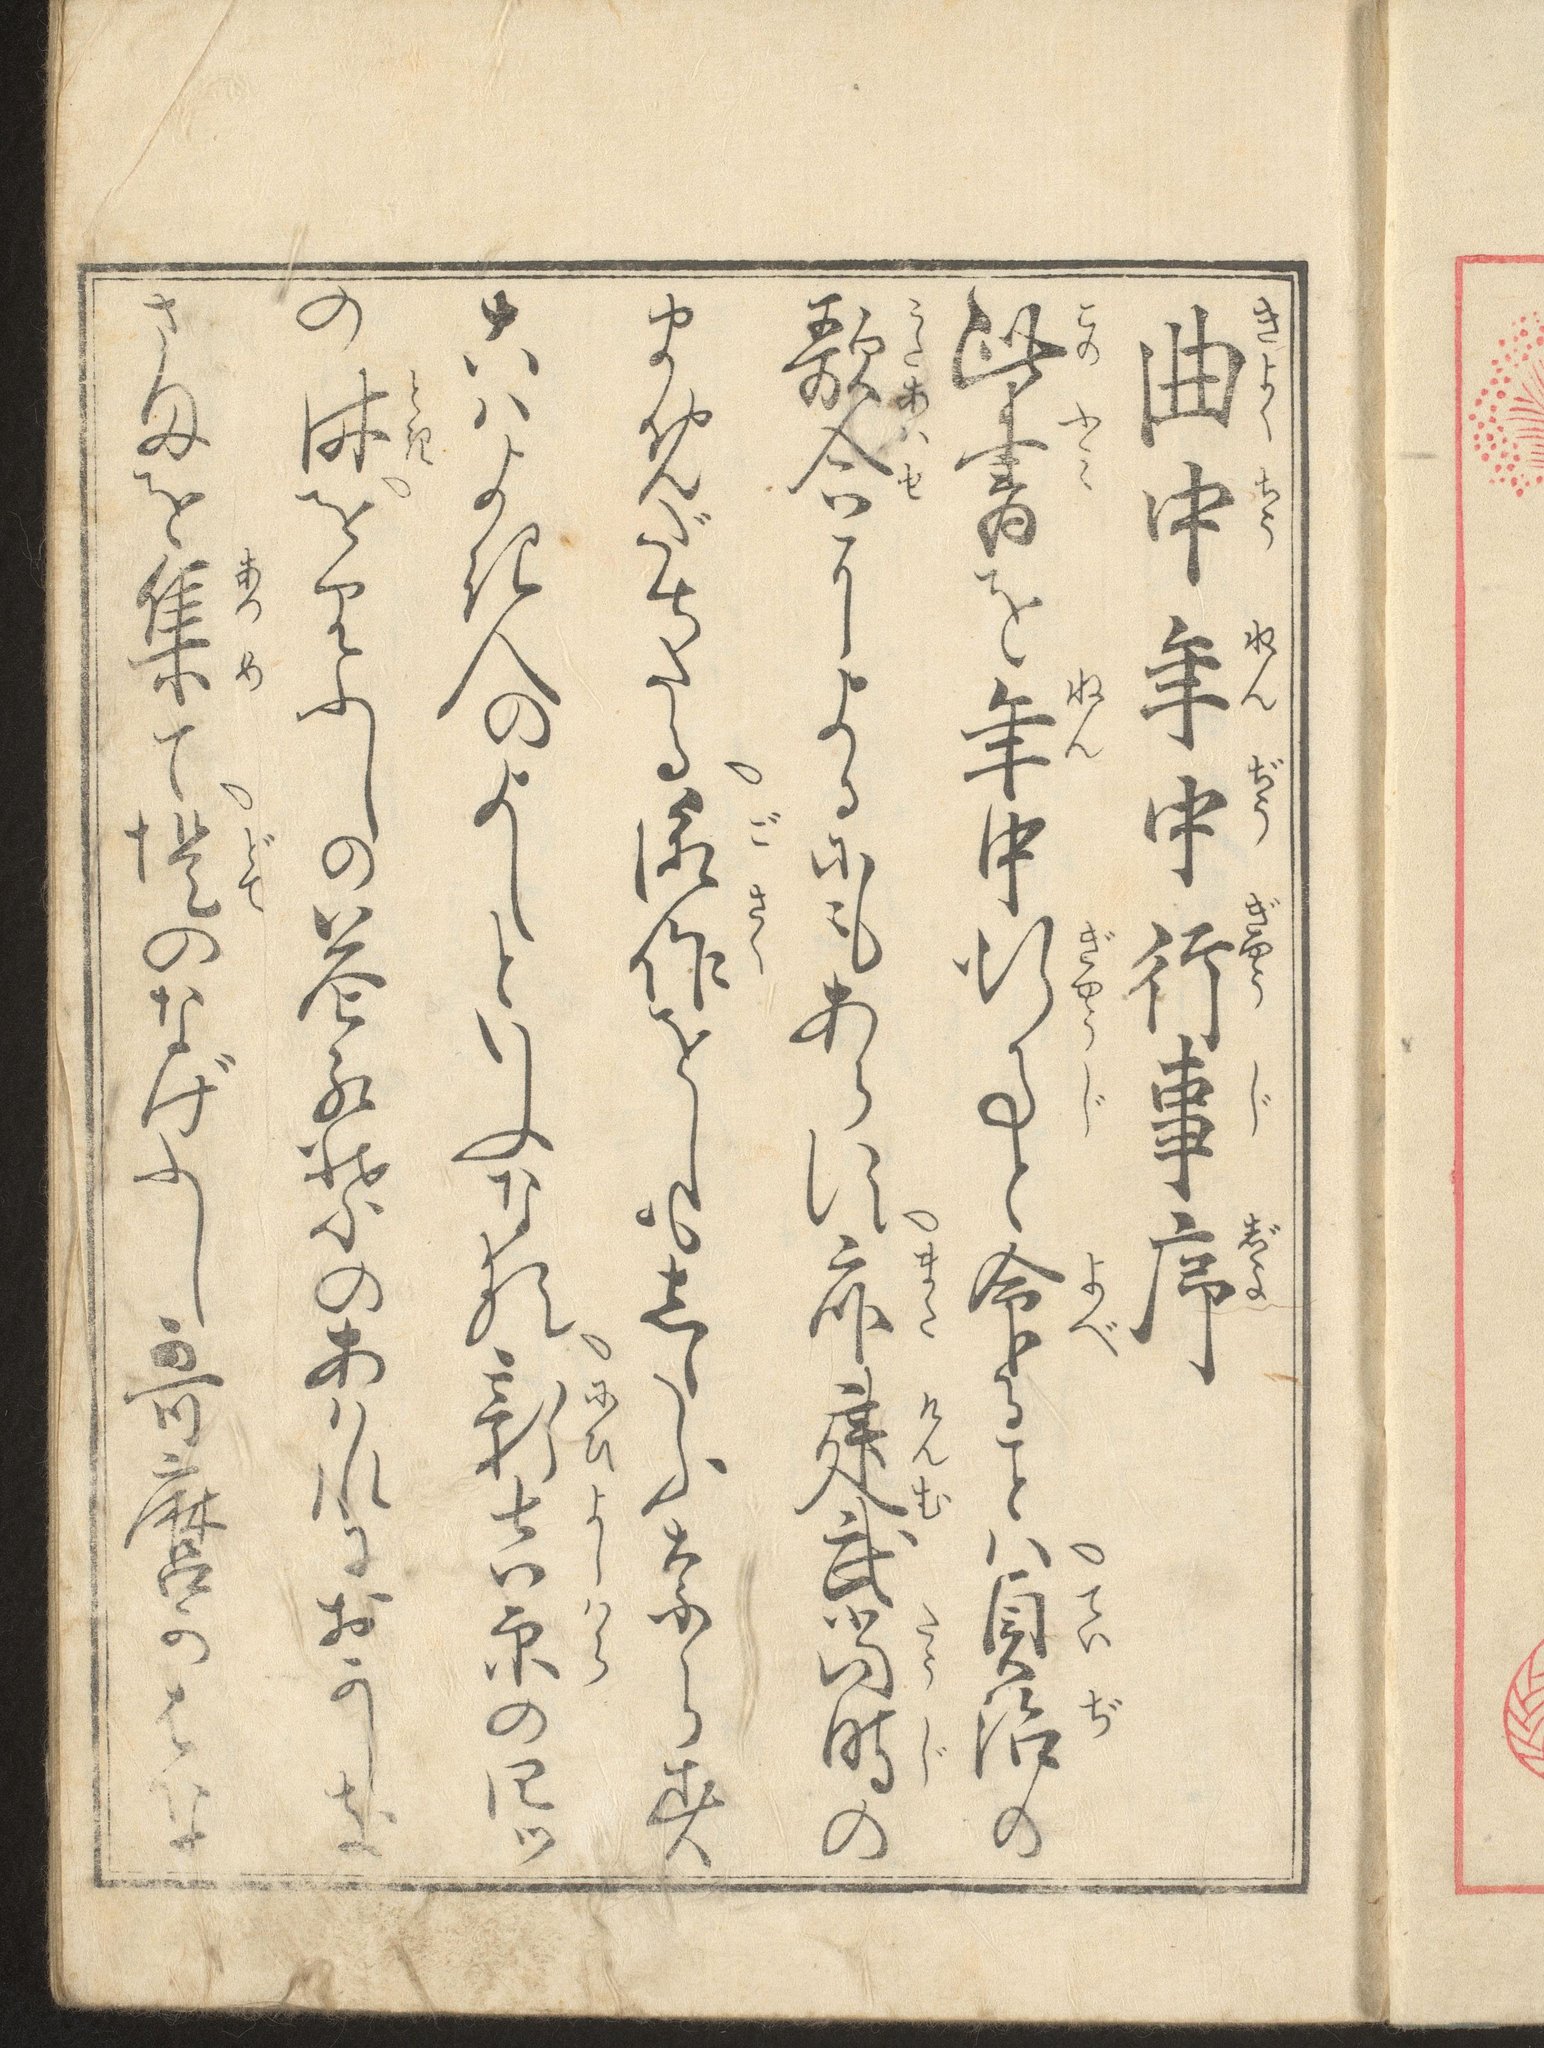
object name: page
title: Titelpagina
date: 1804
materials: paper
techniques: woodcut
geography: edo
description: Binnenkant kaft (titelpagina) en eerste tekstpagina van deel één van Utamaro`s boek: Gebeurtenissen in de lusthuizen gedurende het jaar.